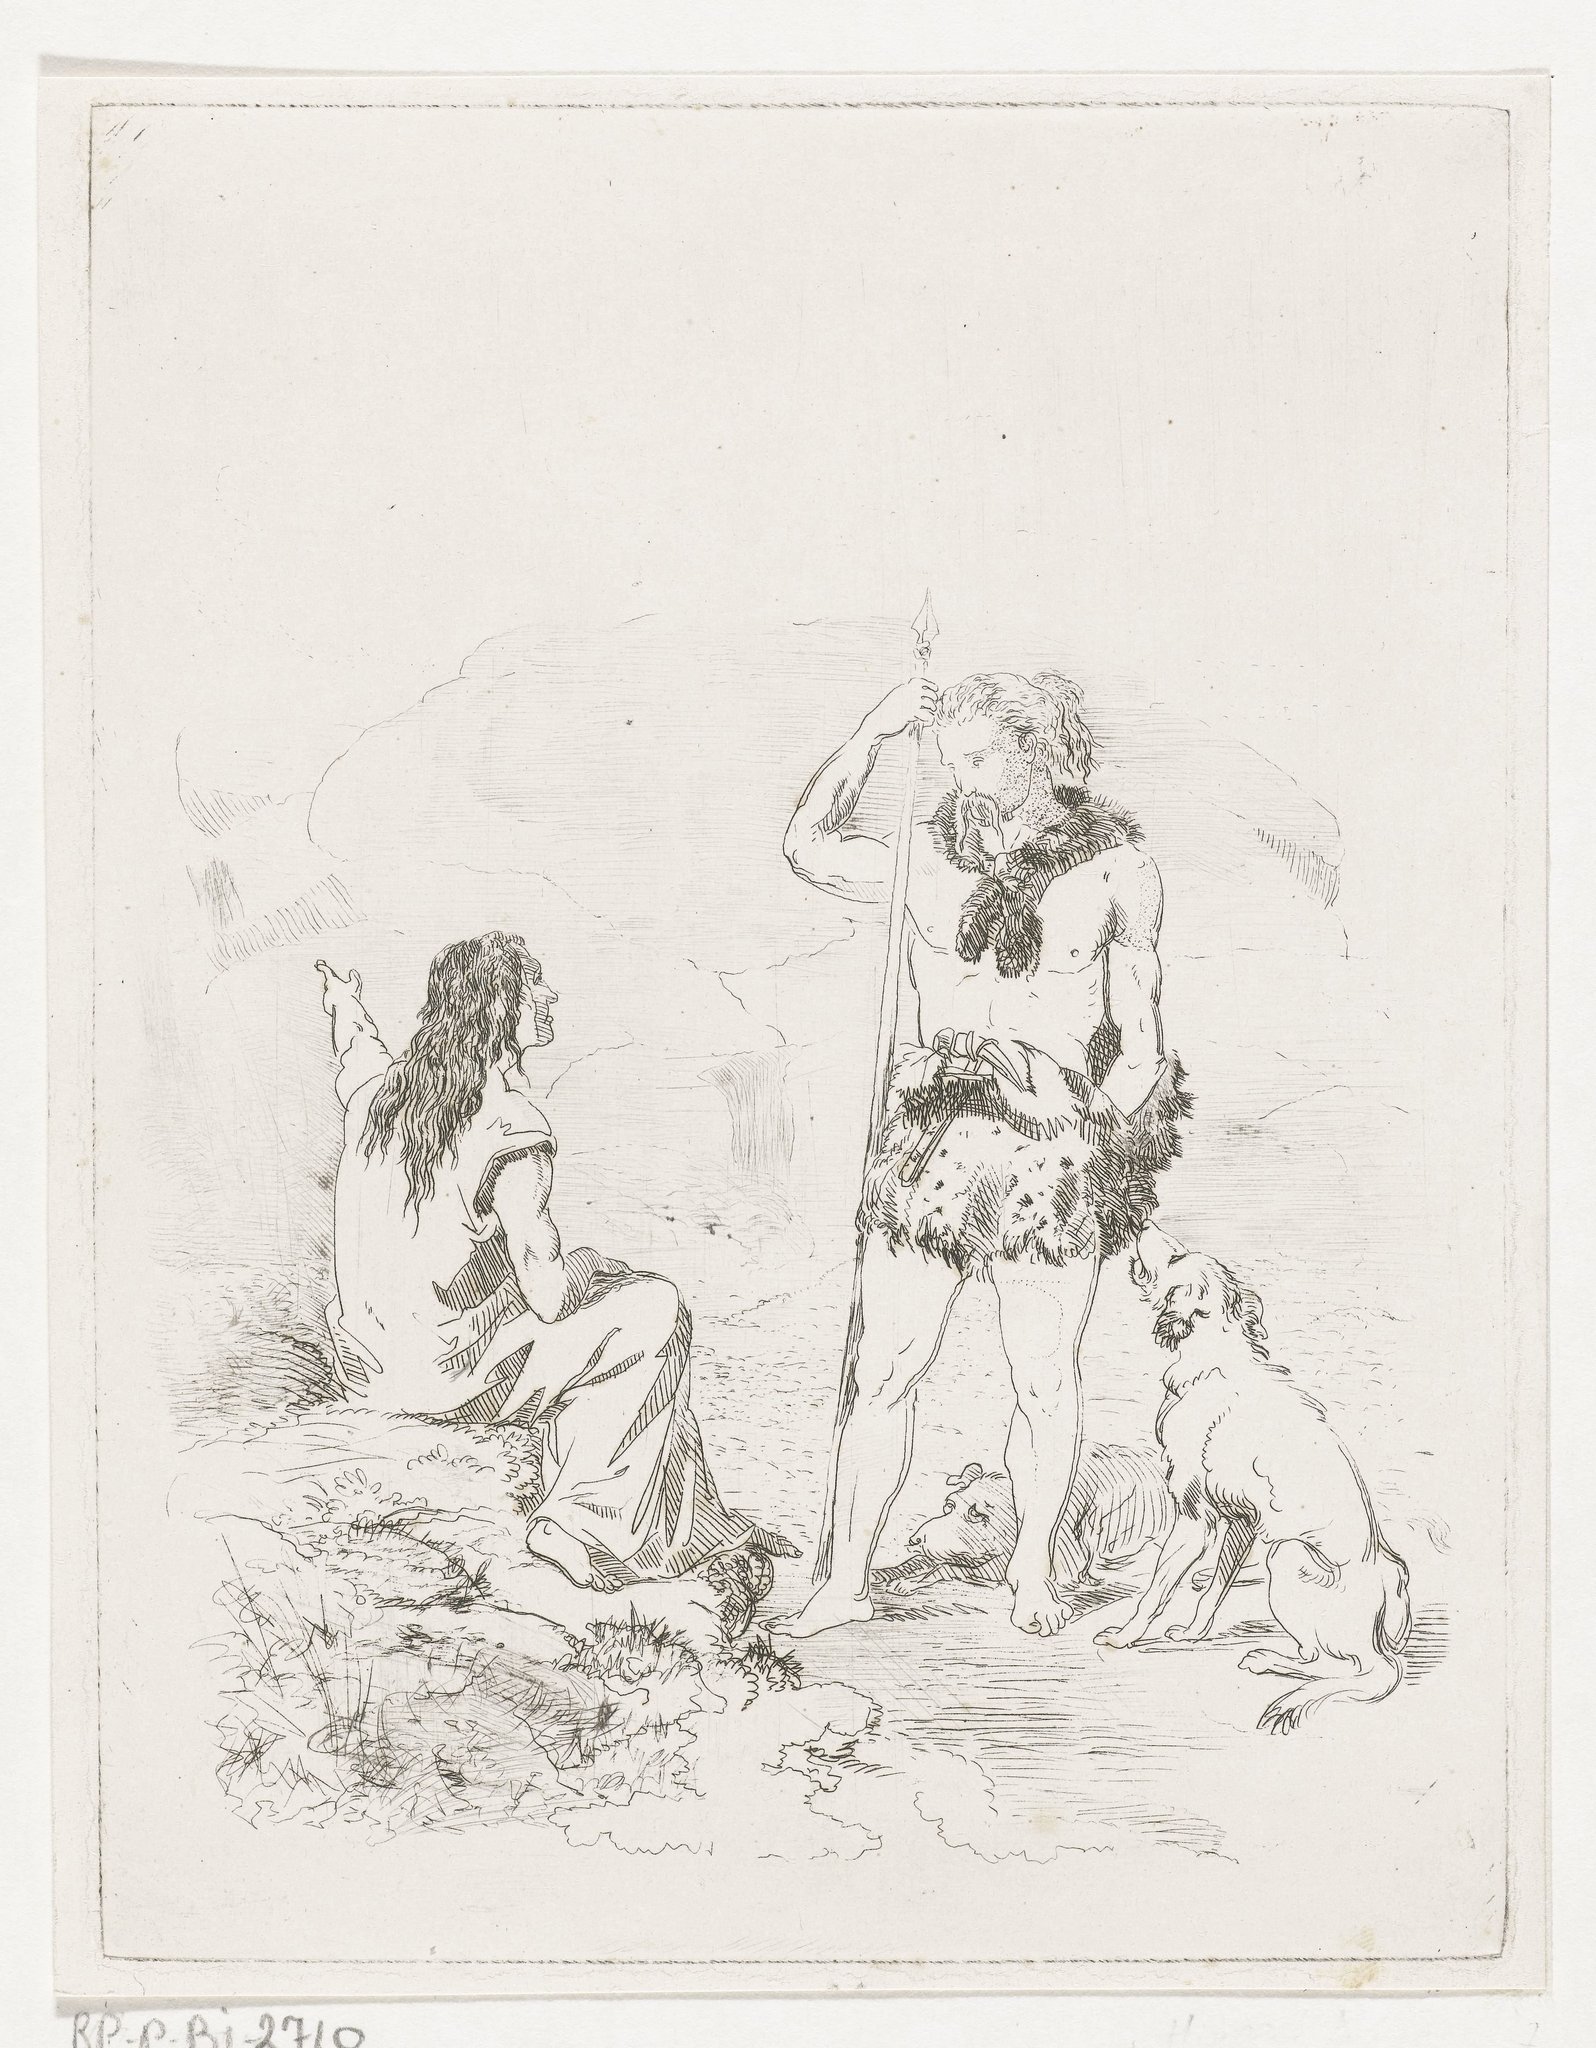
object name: print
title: Aeddon spreekt met een herderin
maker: karel frederik bombled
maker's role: draughtsman, print maker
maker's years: 1822-1902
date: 1852-1902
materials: paper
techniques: etching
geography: delft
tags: tales and fairy tales (aeddon), extinct, 'historical' peoples: gauls (+ women), extinct, 'historical' peoples: gauls (+ men), dog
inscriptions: collector's mark: Lugt 2228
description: Een herderin vertelt aan Aeddon wat er gebeurd is met Olwene en haar familie. Aeddon heeft een speer vast en wordt door twee honden vergezeld. Illustratie bij de vierde zang van het episch lofgedicht Aeddon.